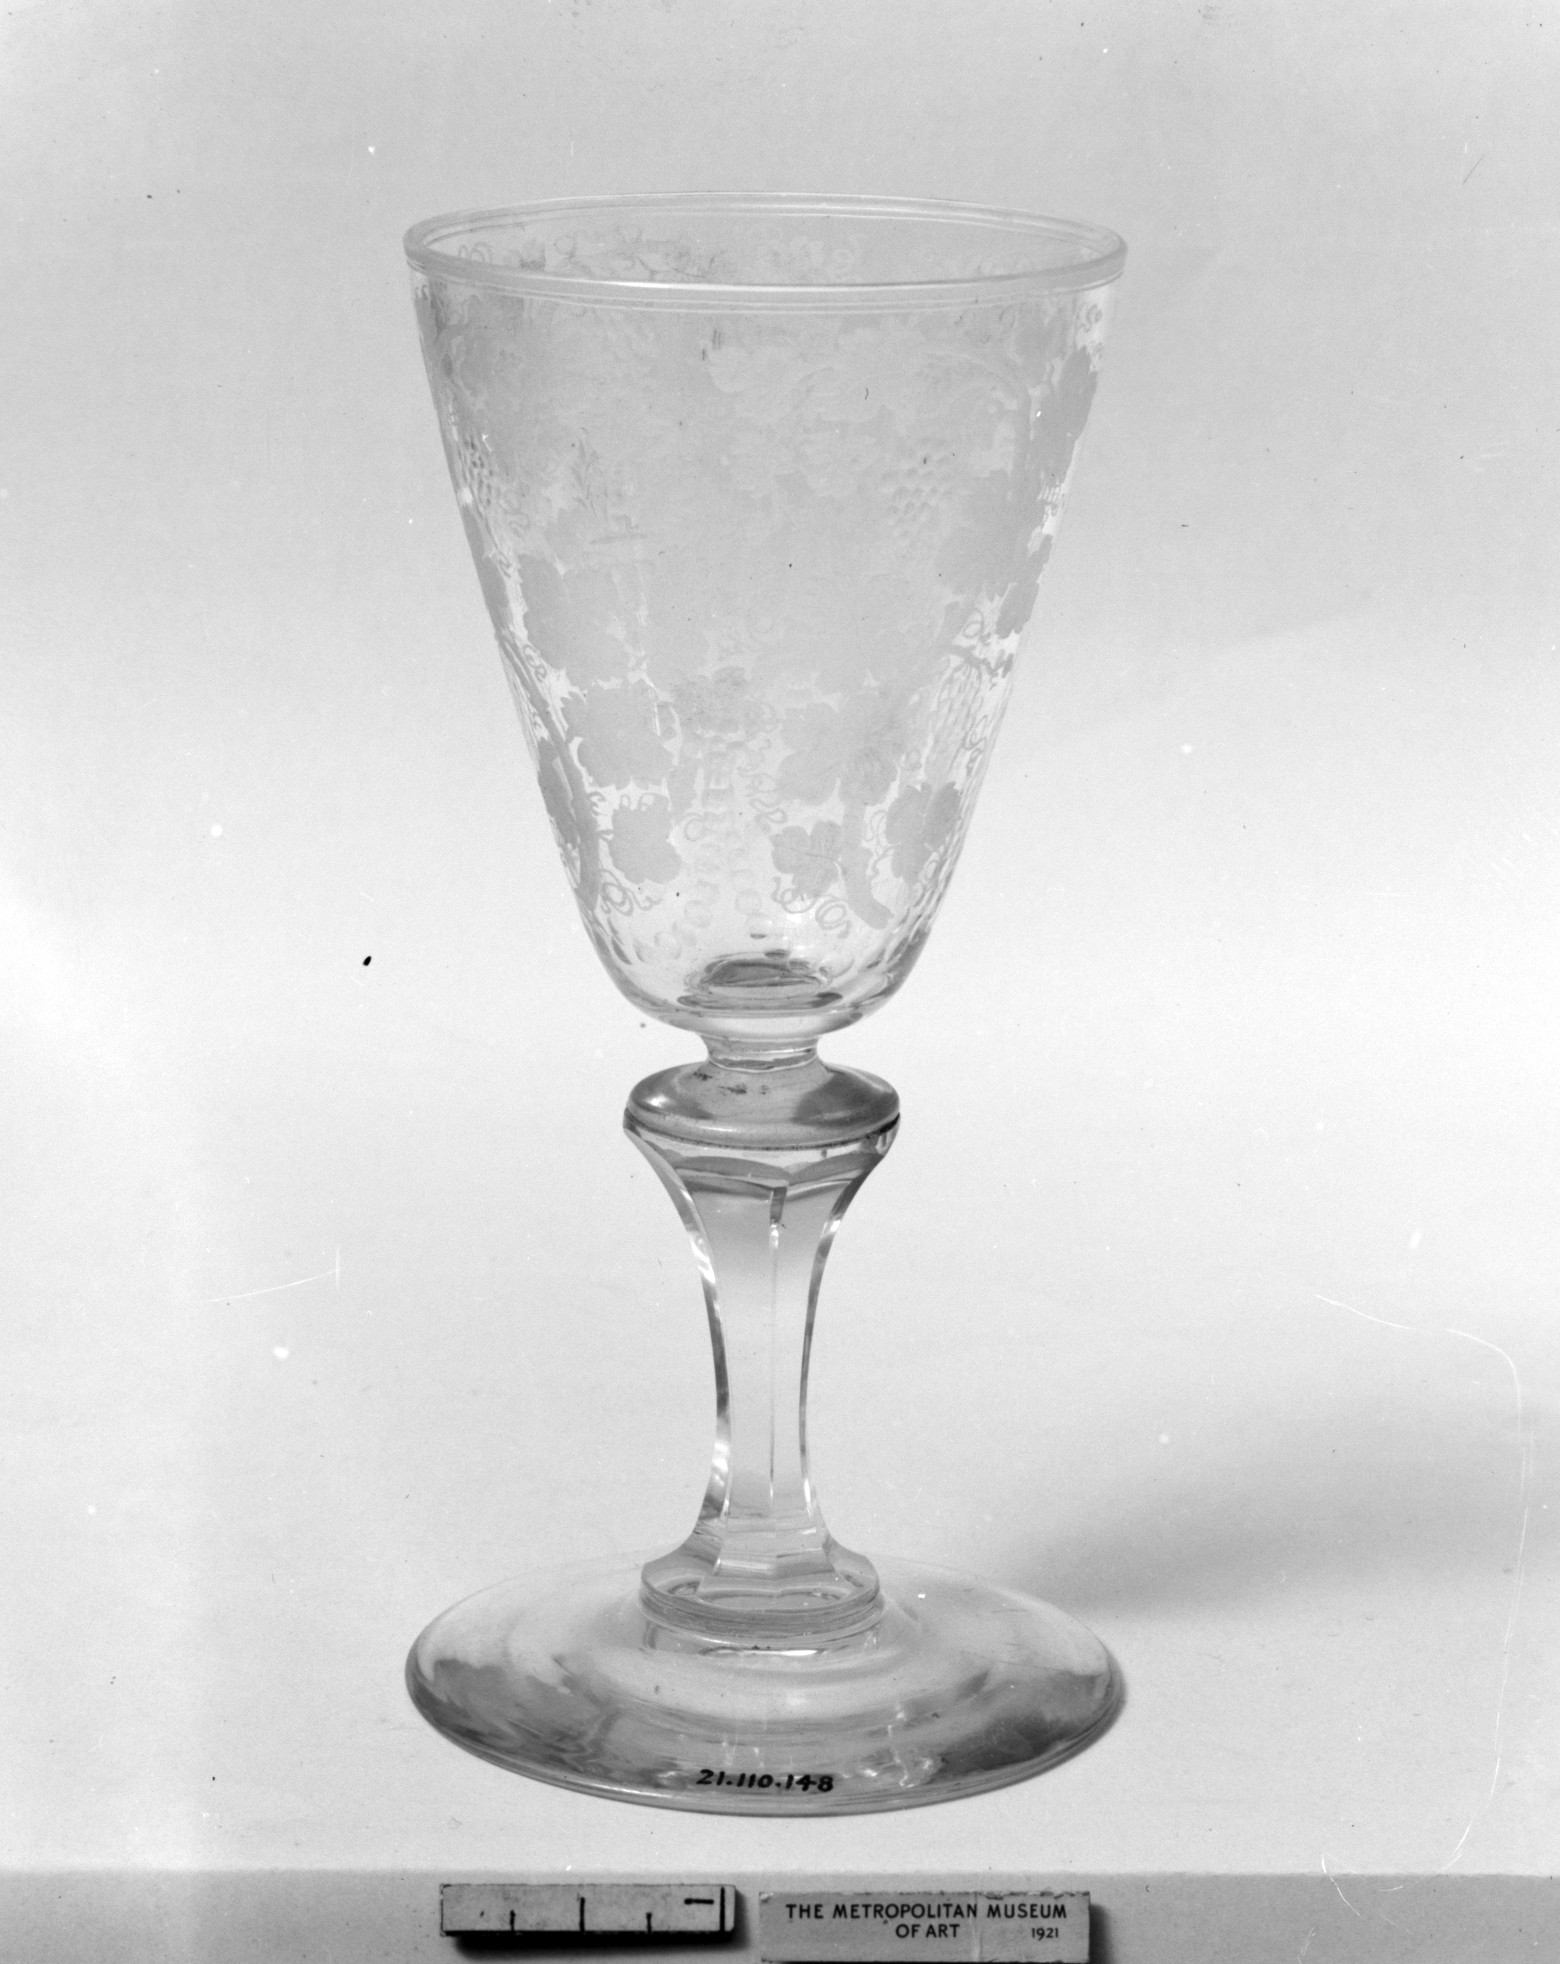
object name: wineglass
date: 1750-1800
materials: glass